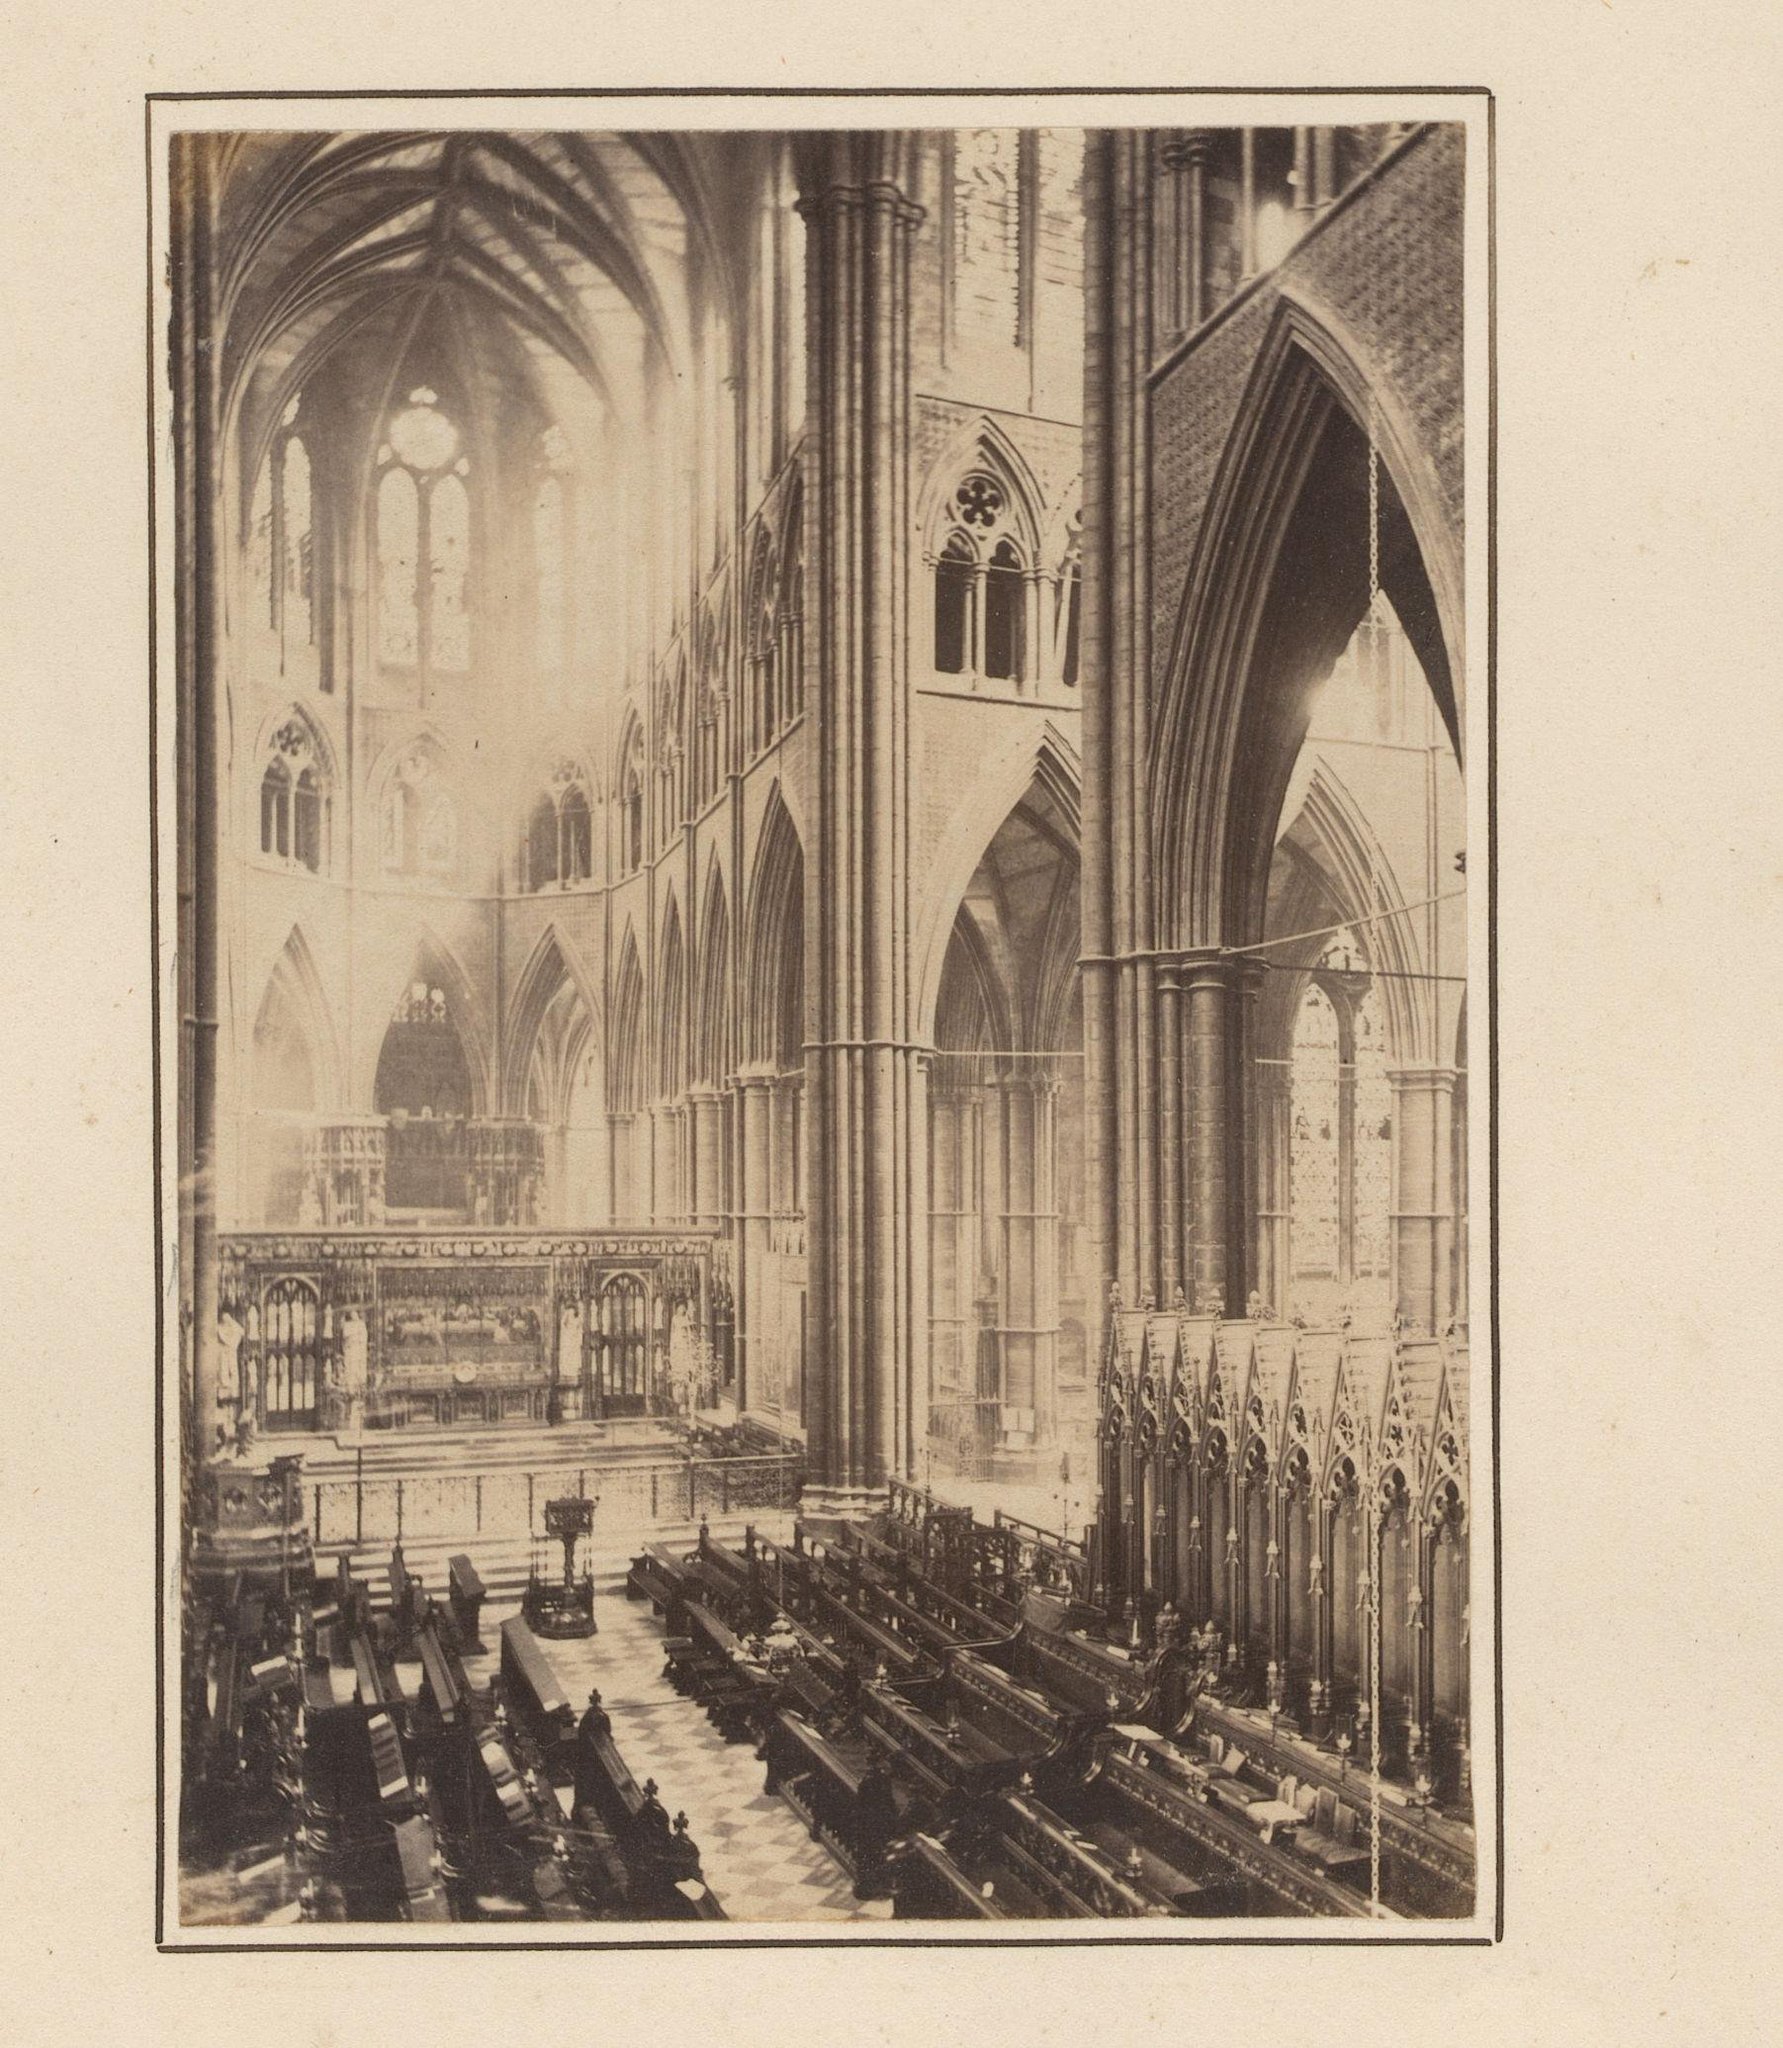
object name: album leaf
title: Koor van Westminster Abbey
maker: Anonymous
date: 1870-1890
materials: paper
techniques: albumen print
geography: westminster abbey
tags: parts of church interior: choir, westminster abbey